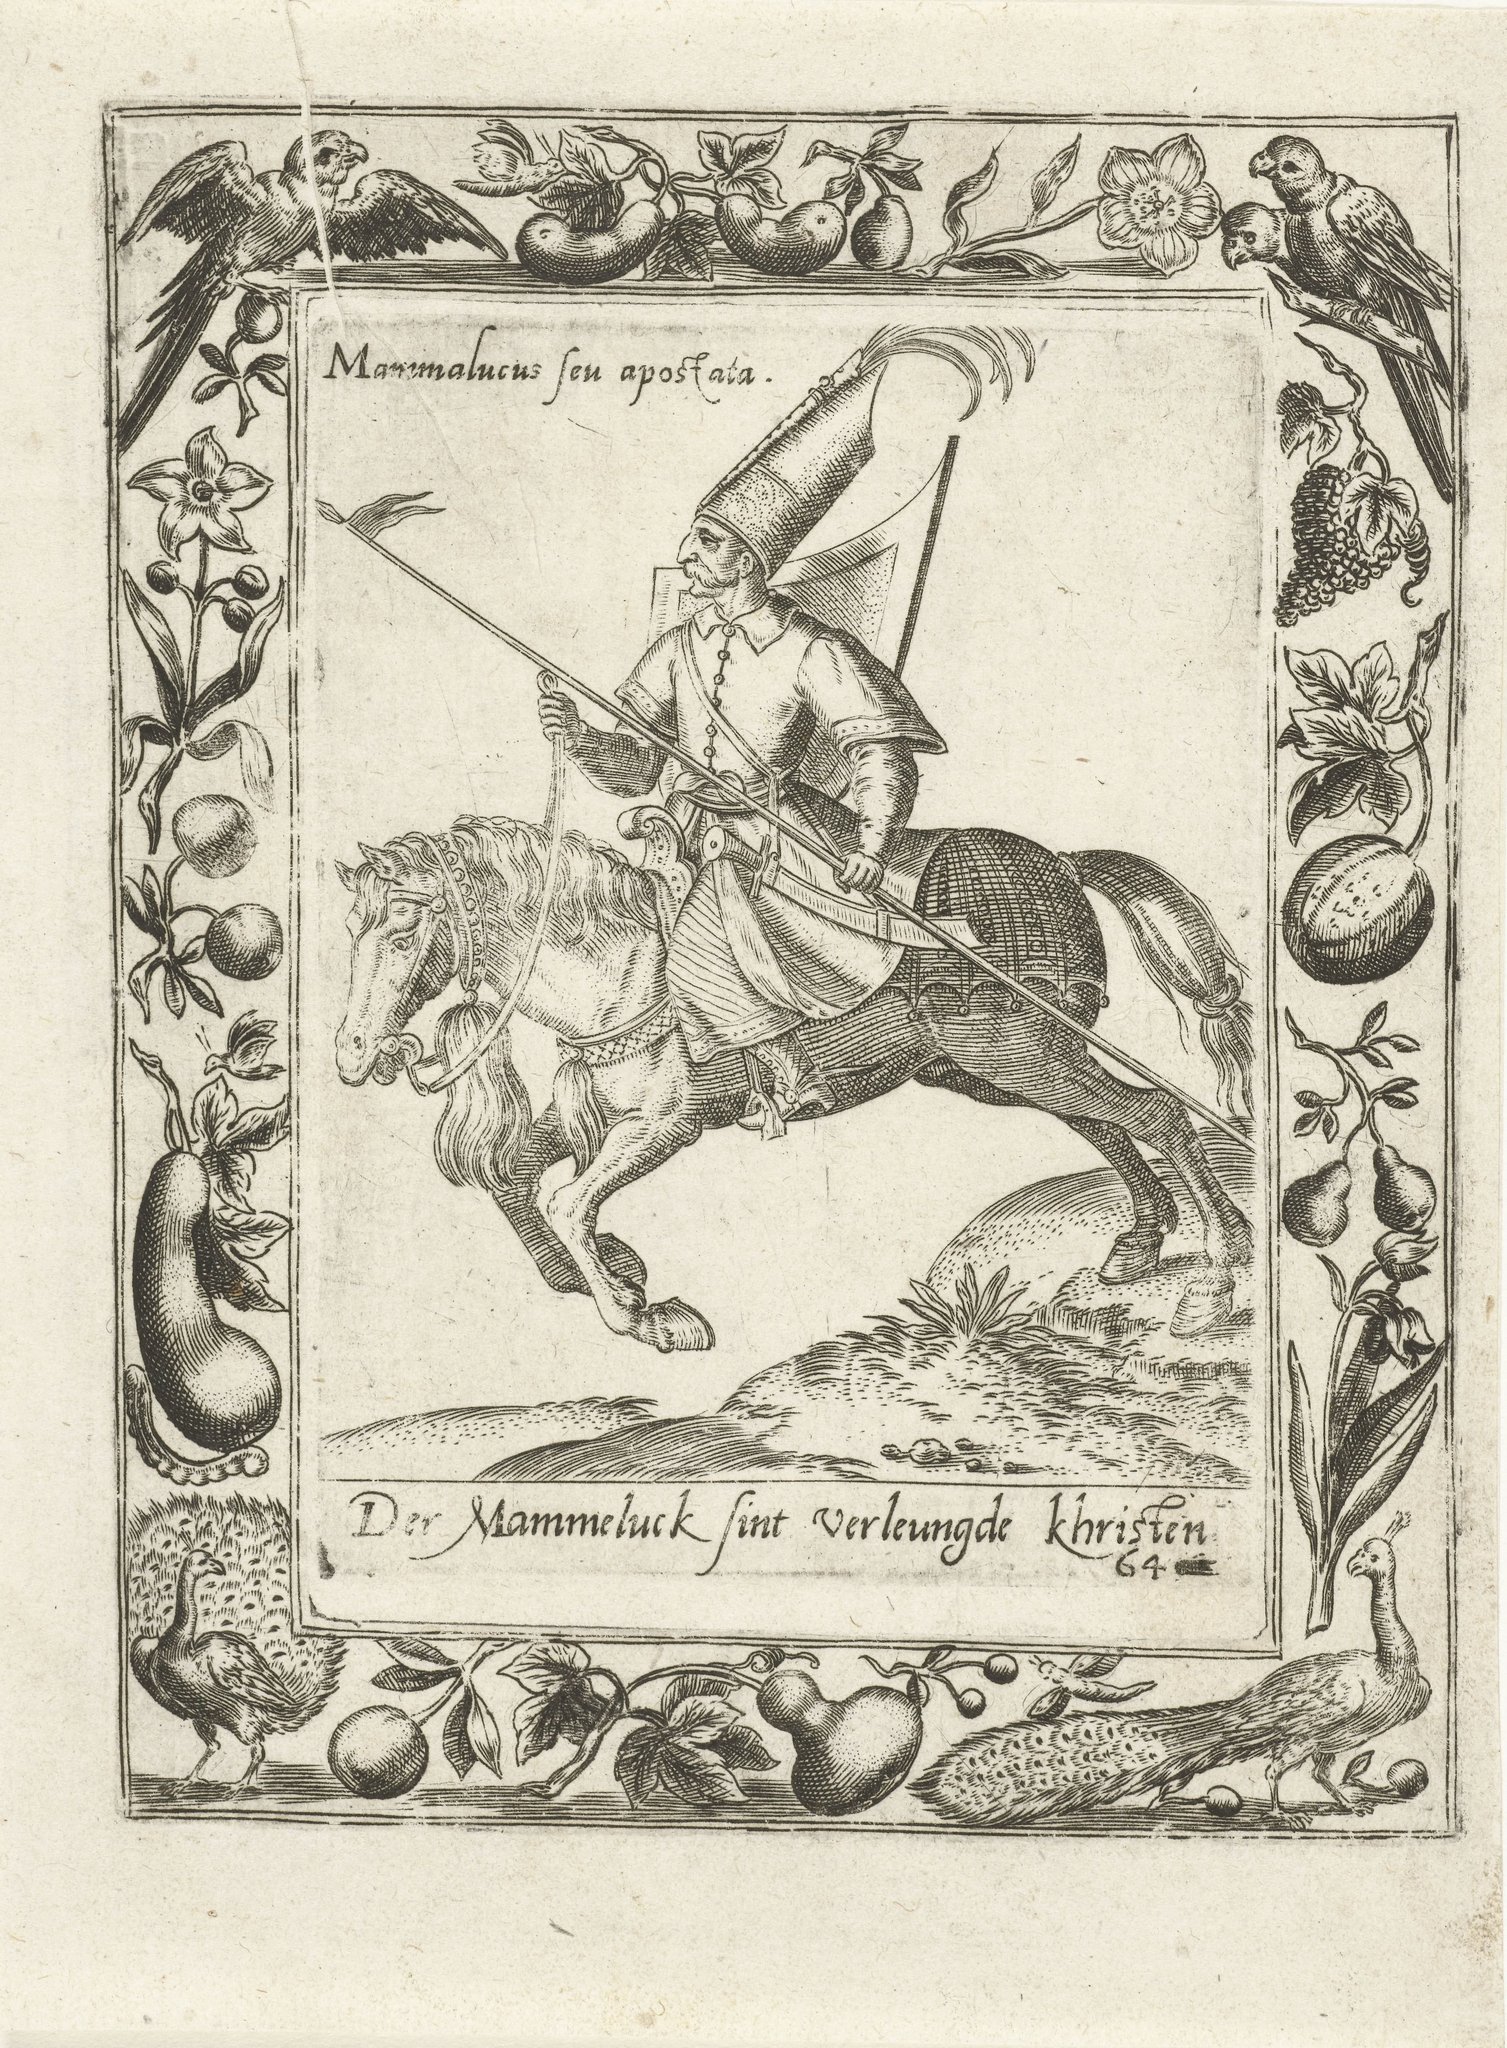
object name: costume print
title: Mammeluk te paard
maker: abraham de bruyn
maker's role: print maker, publisher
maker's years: 1540-1587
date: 1577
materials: paper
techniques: engraving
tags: asiatic races and peoples: turks, slavery; serfs and enslaved persons, warfare; military affairs (+ cavalry, horsemen), folk costume, regional costume, (military) uniforms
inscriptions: collector's mark: Lugt 2228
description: Cartouche met afbeelding van paard en ruiter naar links. Het paard is in galop. De ruiter is een Mammelukse soldaat . Hij heeft een speer in zijn hand. De prent heeft een Duits onderschrift en Latijns opschrift. Prent oorspronkelijk uit 'Equitum descripcio...', 1577.